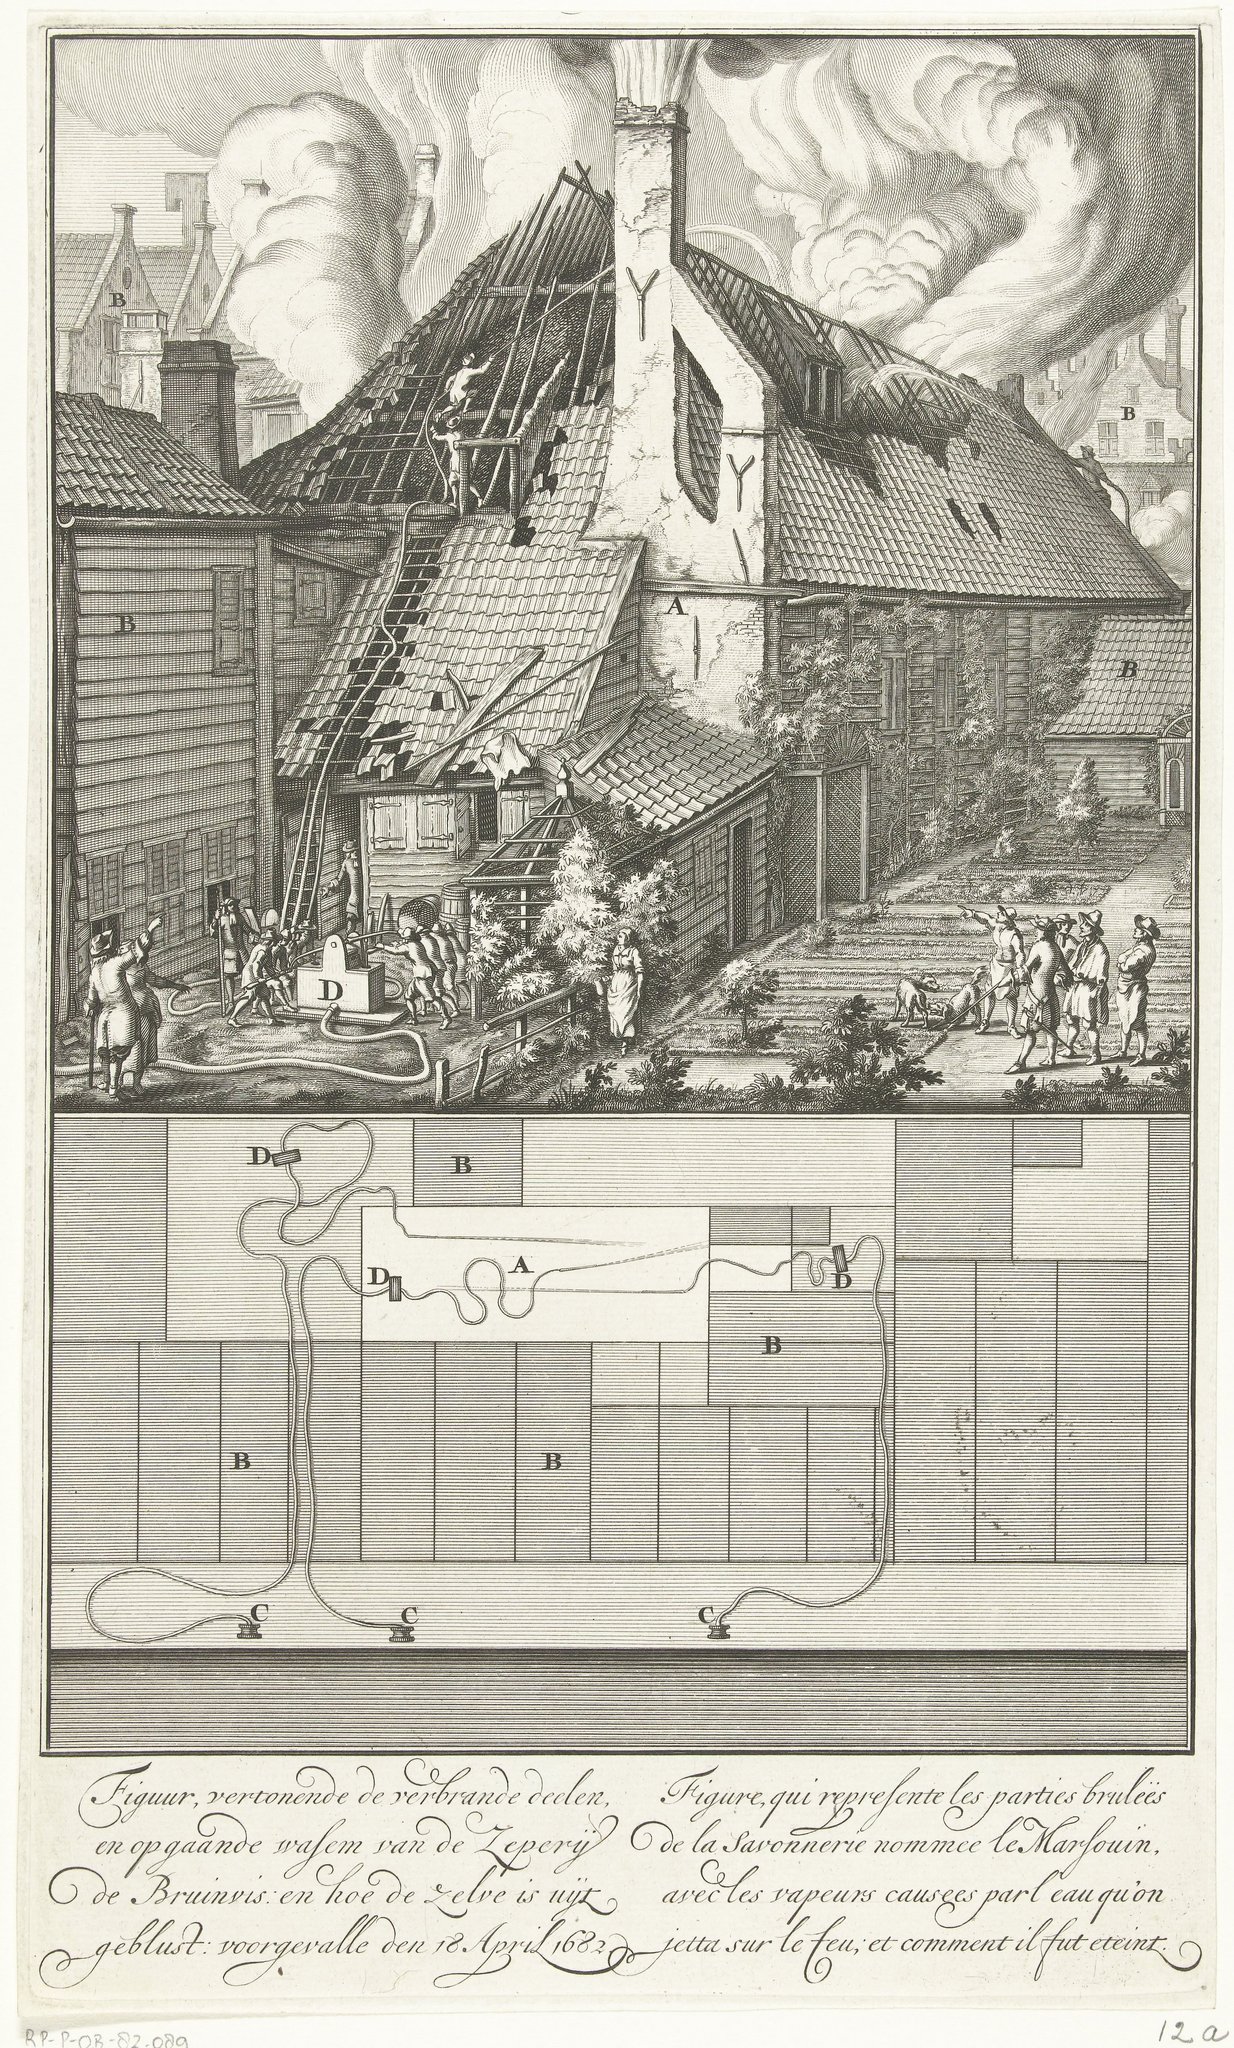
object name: book illustration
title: De gebluste brand in de zeepziederij De Bruinvis, 1682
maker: jan van der heyden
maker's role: draughtsman, painter, print maker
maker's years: 1637-1712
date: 1690-1735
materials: paper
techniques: engraving, etching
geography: amsterdam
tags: painter, print maker, draughtsman, jan van der heyden, ruin of a building ~ architecture, fire-fighting, fire-extinguishing equipment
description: Prent ook gebruikt in: Heyden, Jan van der. Beschryving der nieuwlyks uitgevonden en geoctrojeerde slang-brand-spuiten en haare wyze van brand-blussen, tegenwoordig binnen Amsterdam in gebruik zijnde (…). 1e druk. Amsterdam: Jan Rieuwertsz. (II), 1690. En in: Heyden, Jan van der. Beschryving der nieuwlyks uitgevonden en geoctrojeerde slang-brand-spuiten en haare wyze van brand-blussen, tegenwoordig binnen Amsterdam in gebruik zijnde (…). 2e druk. Amsterdam: erfgenamen Jan van der Heyden, 1735. Voor voorstudie voor ontwerptekening zie RP-T-1899-A-4209. Voor eerste bekende staat zie RP-P-1944-238. Voor tweede bekende staat zie RP-P-OB-82.090.